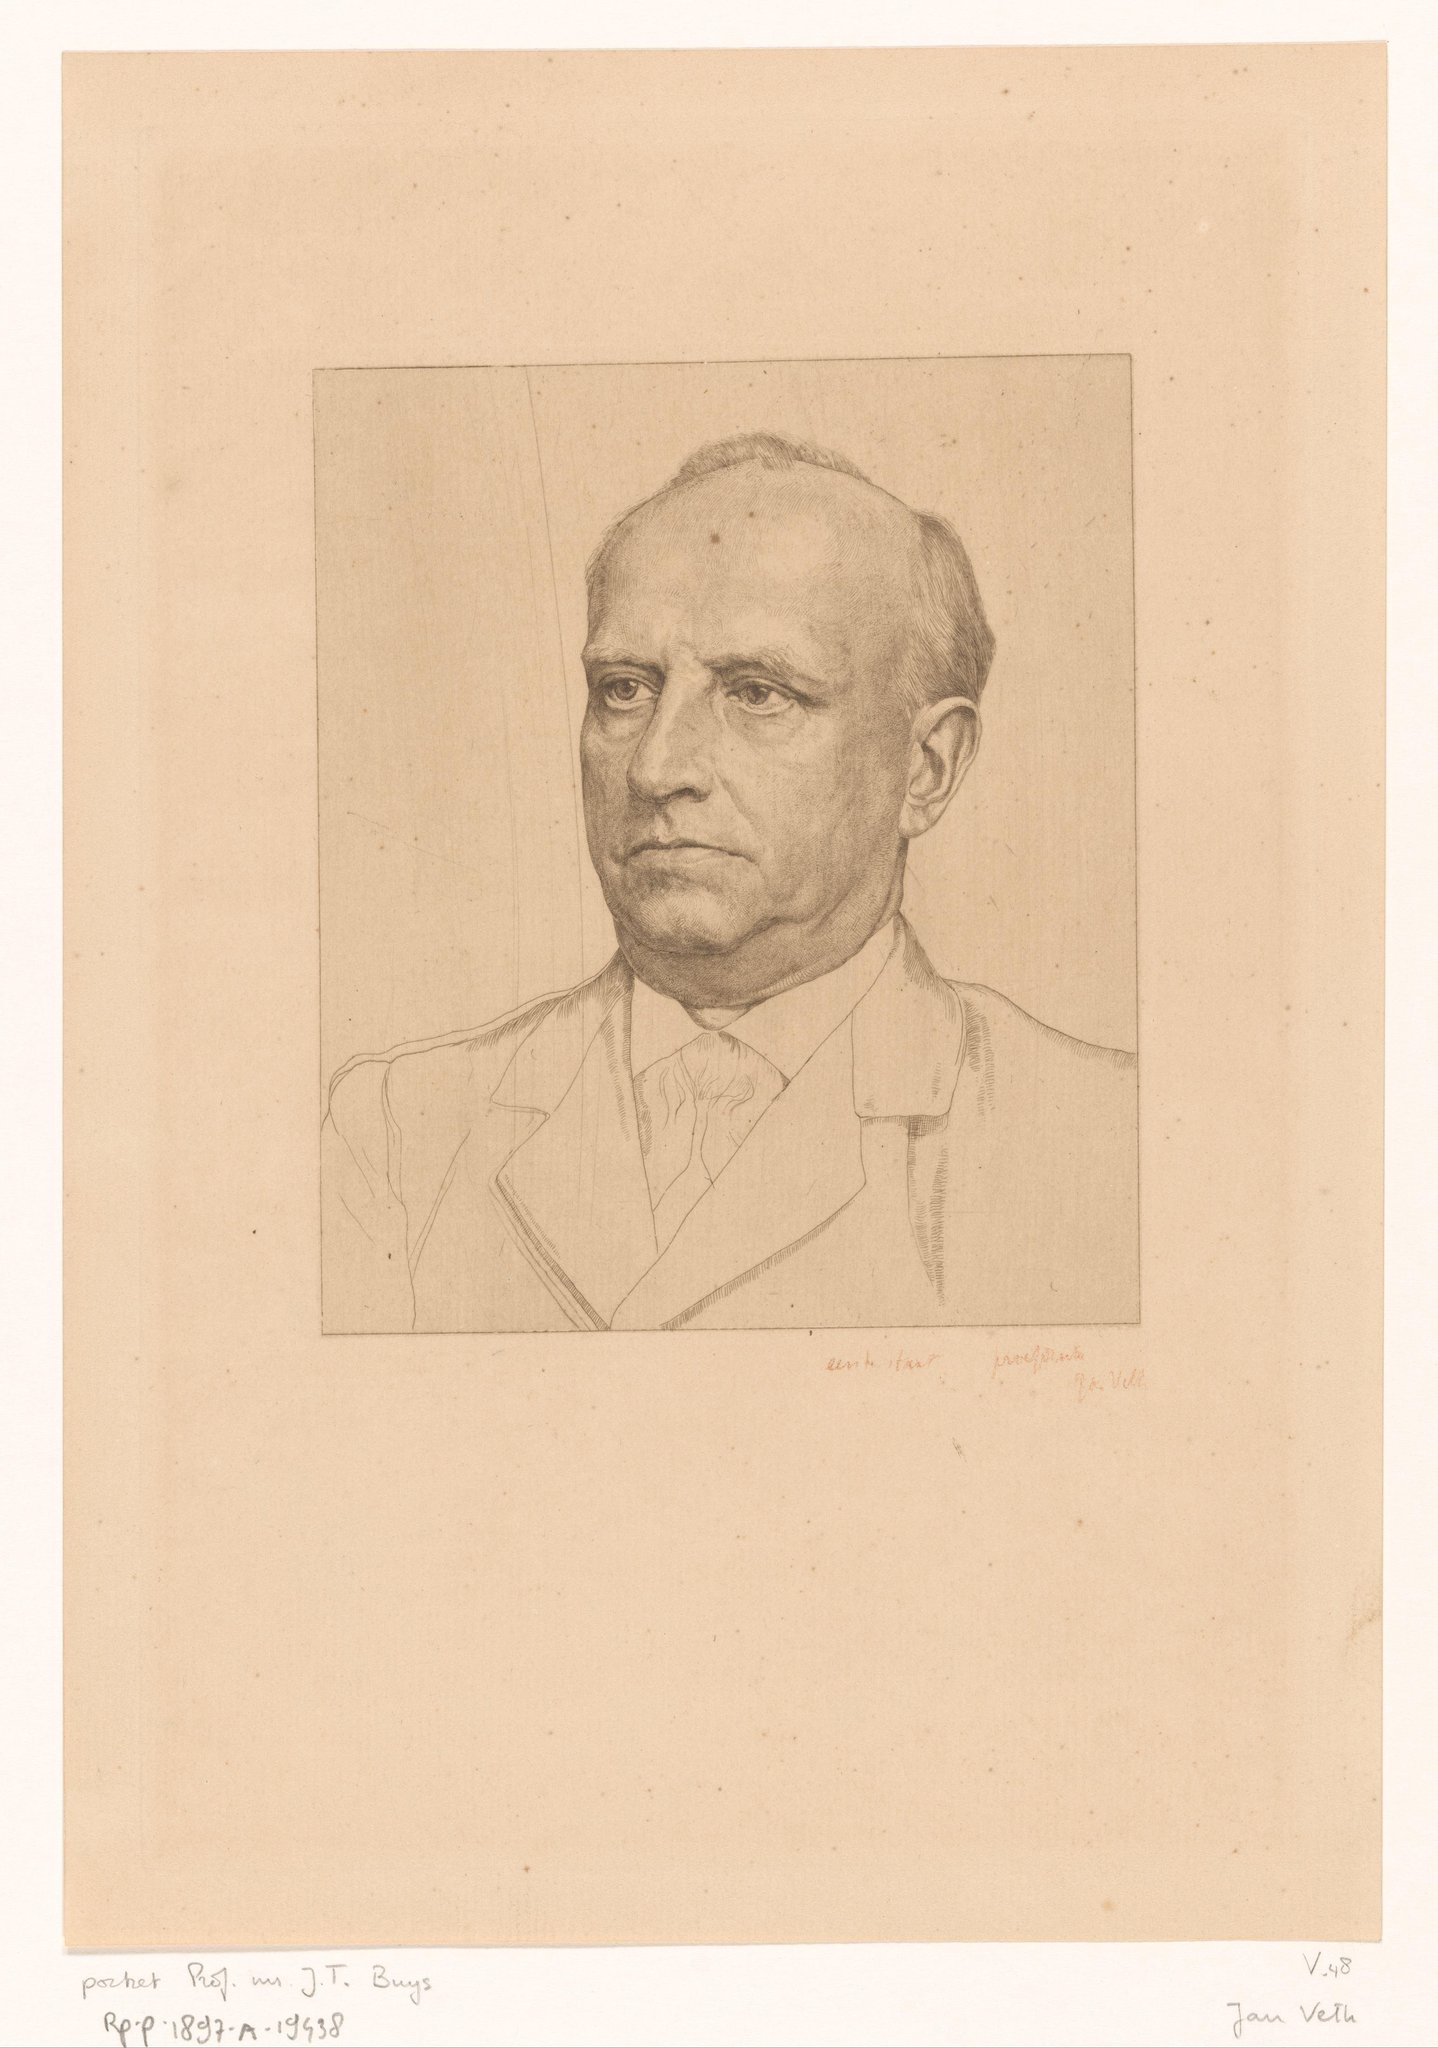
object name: print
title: Portret van Johannes Theodoor Buys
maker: jan veth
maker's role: designer, draughtsman, painter, print maker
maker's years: 1864-1925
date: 1893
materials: paper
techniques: drypoint, etching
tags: warmond, historical persons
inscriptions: collector's mark: Lugt 2228